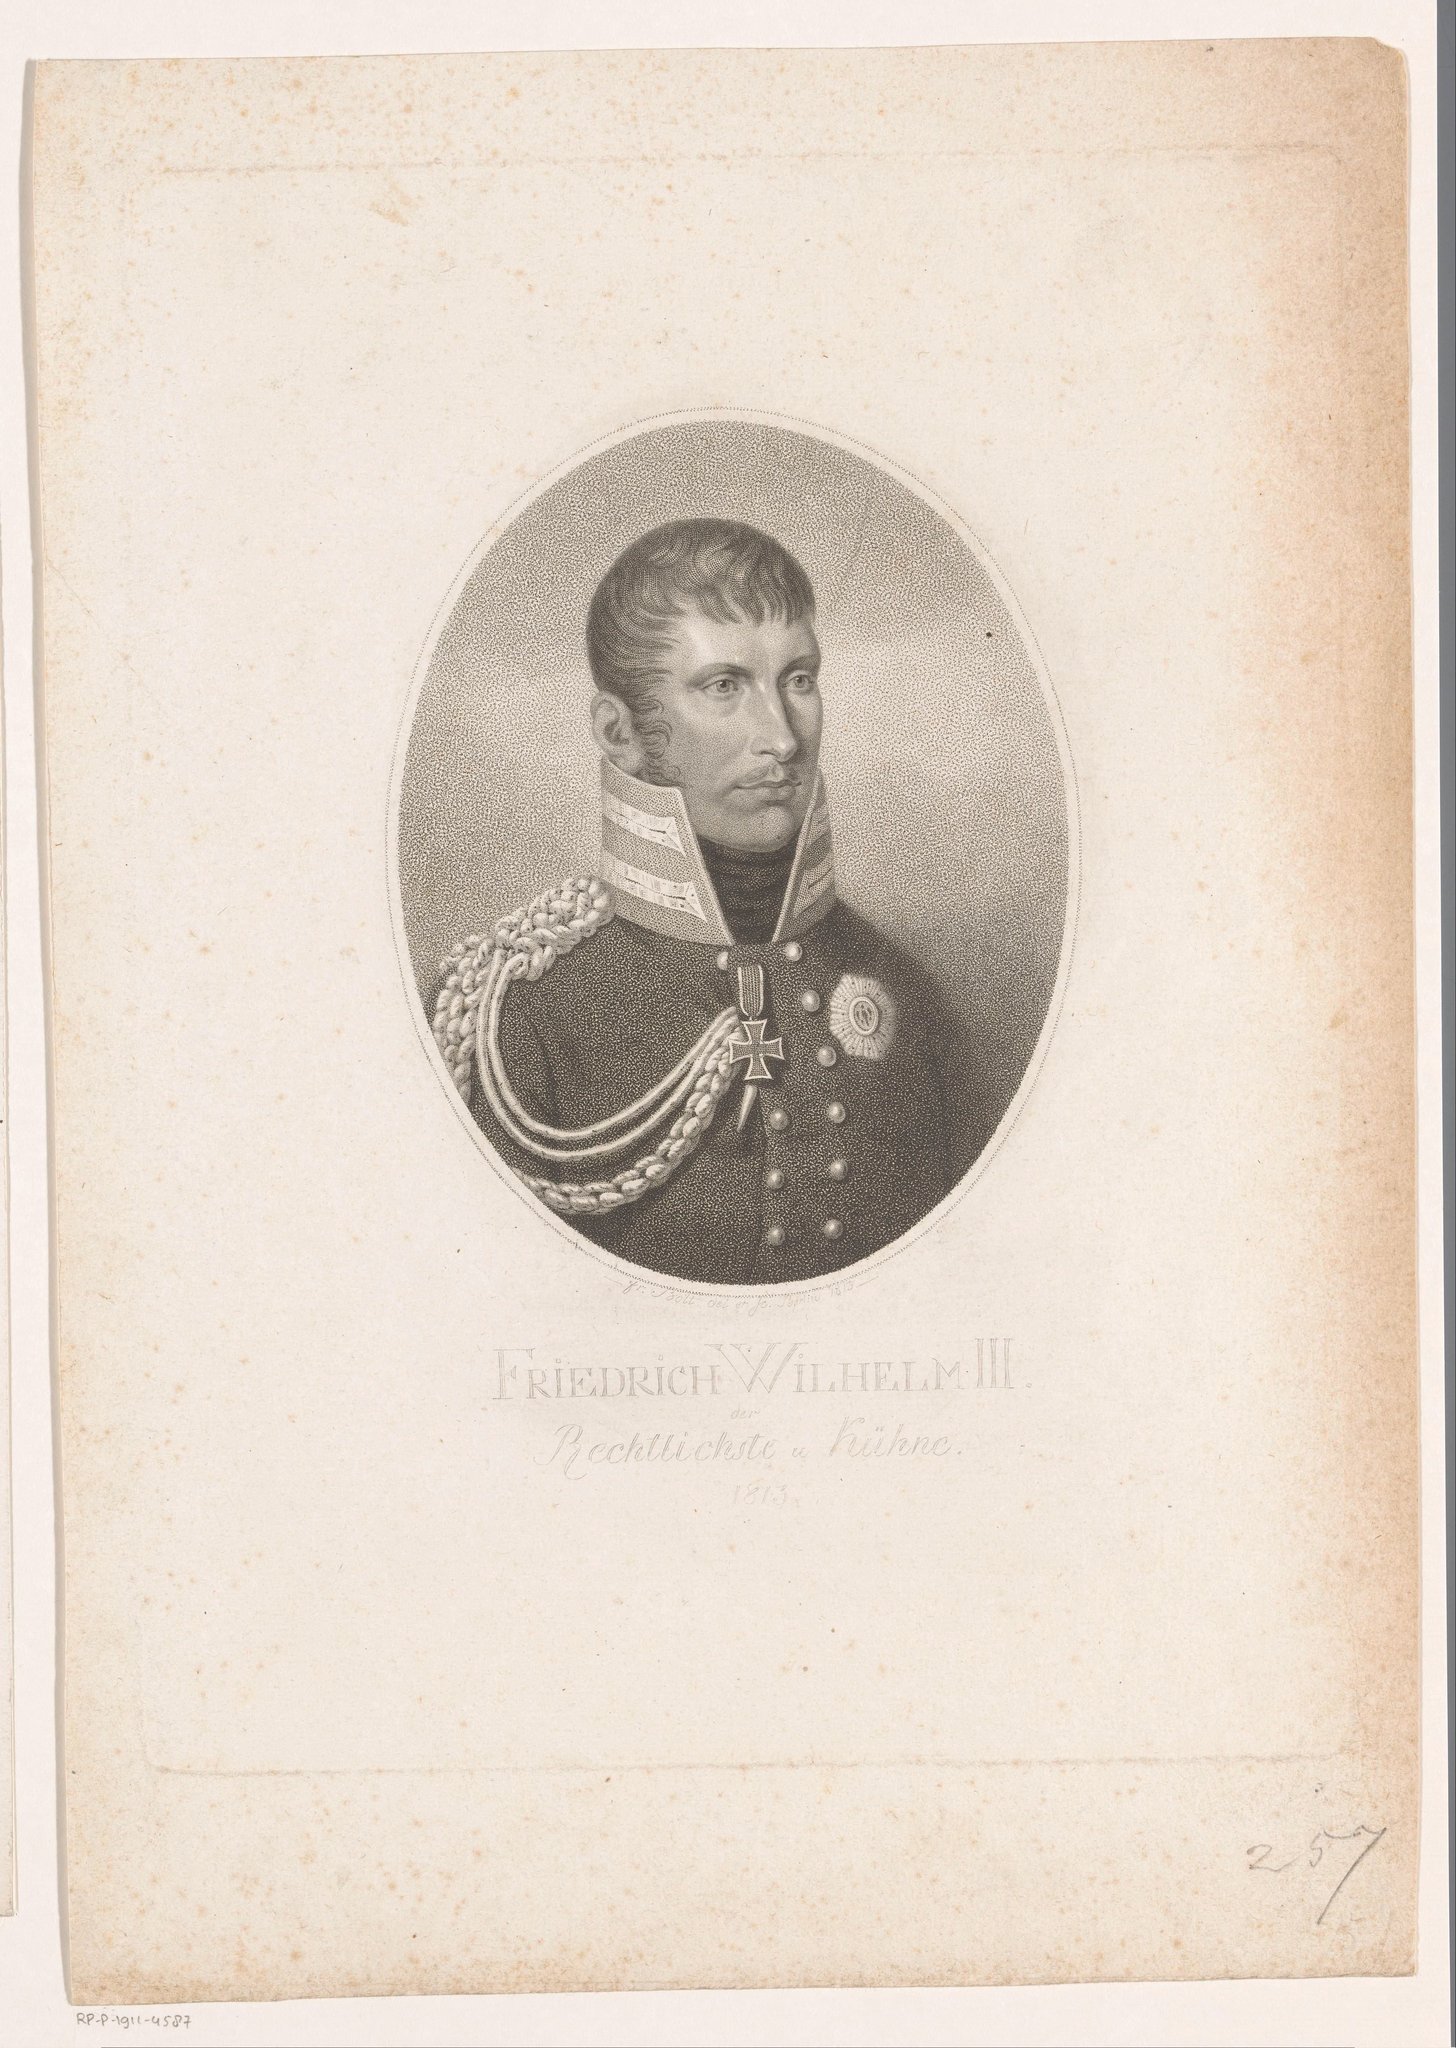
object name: print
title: Portret van Frederik Willem III, koning van Pruisen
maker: johann friedrich bolt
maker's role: print maker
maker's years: 1769-1836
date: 1813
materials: paper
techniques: stippling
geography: berlin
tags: berlin, frederik willem iii koning van pruisen, knighthood order (with name) - insignia of a knighthood order, e.g.: badge, chain (with name of order), historical persons, (military) uniforms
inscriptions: collector's mark: Lugt 2228